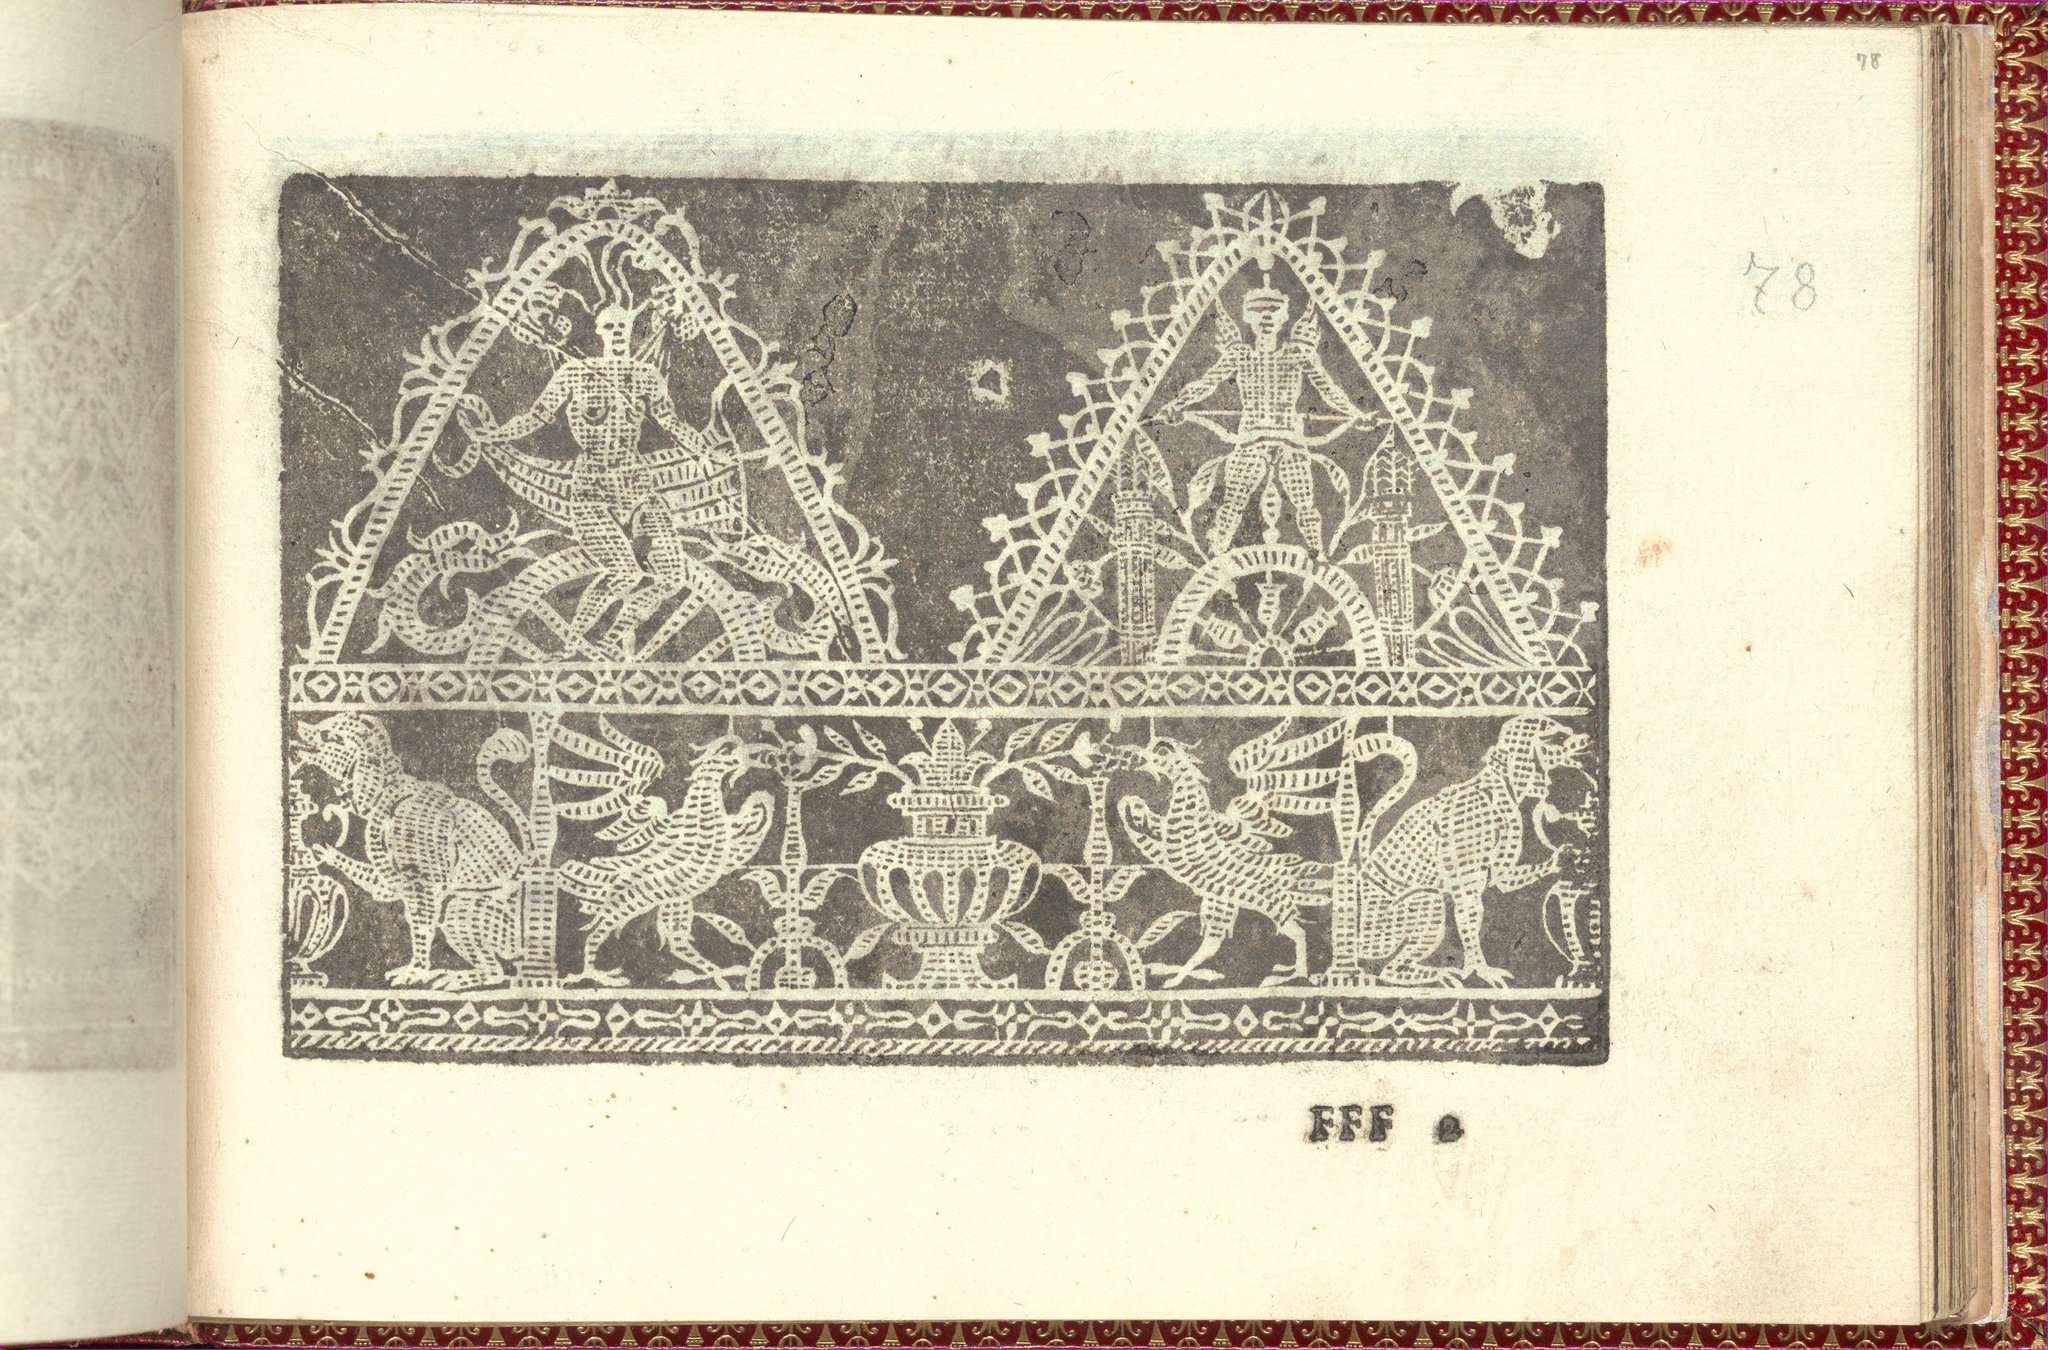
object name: book print ornament architecture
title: Corona delle Nobili et Virtuose Donne: Libro I-IV, page 78 (recto)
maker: cesare vecellio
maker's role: publisher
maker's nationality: italian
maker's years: 1521-1601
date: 1601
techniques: woodcut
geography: italy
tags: birds,cupid,dogs